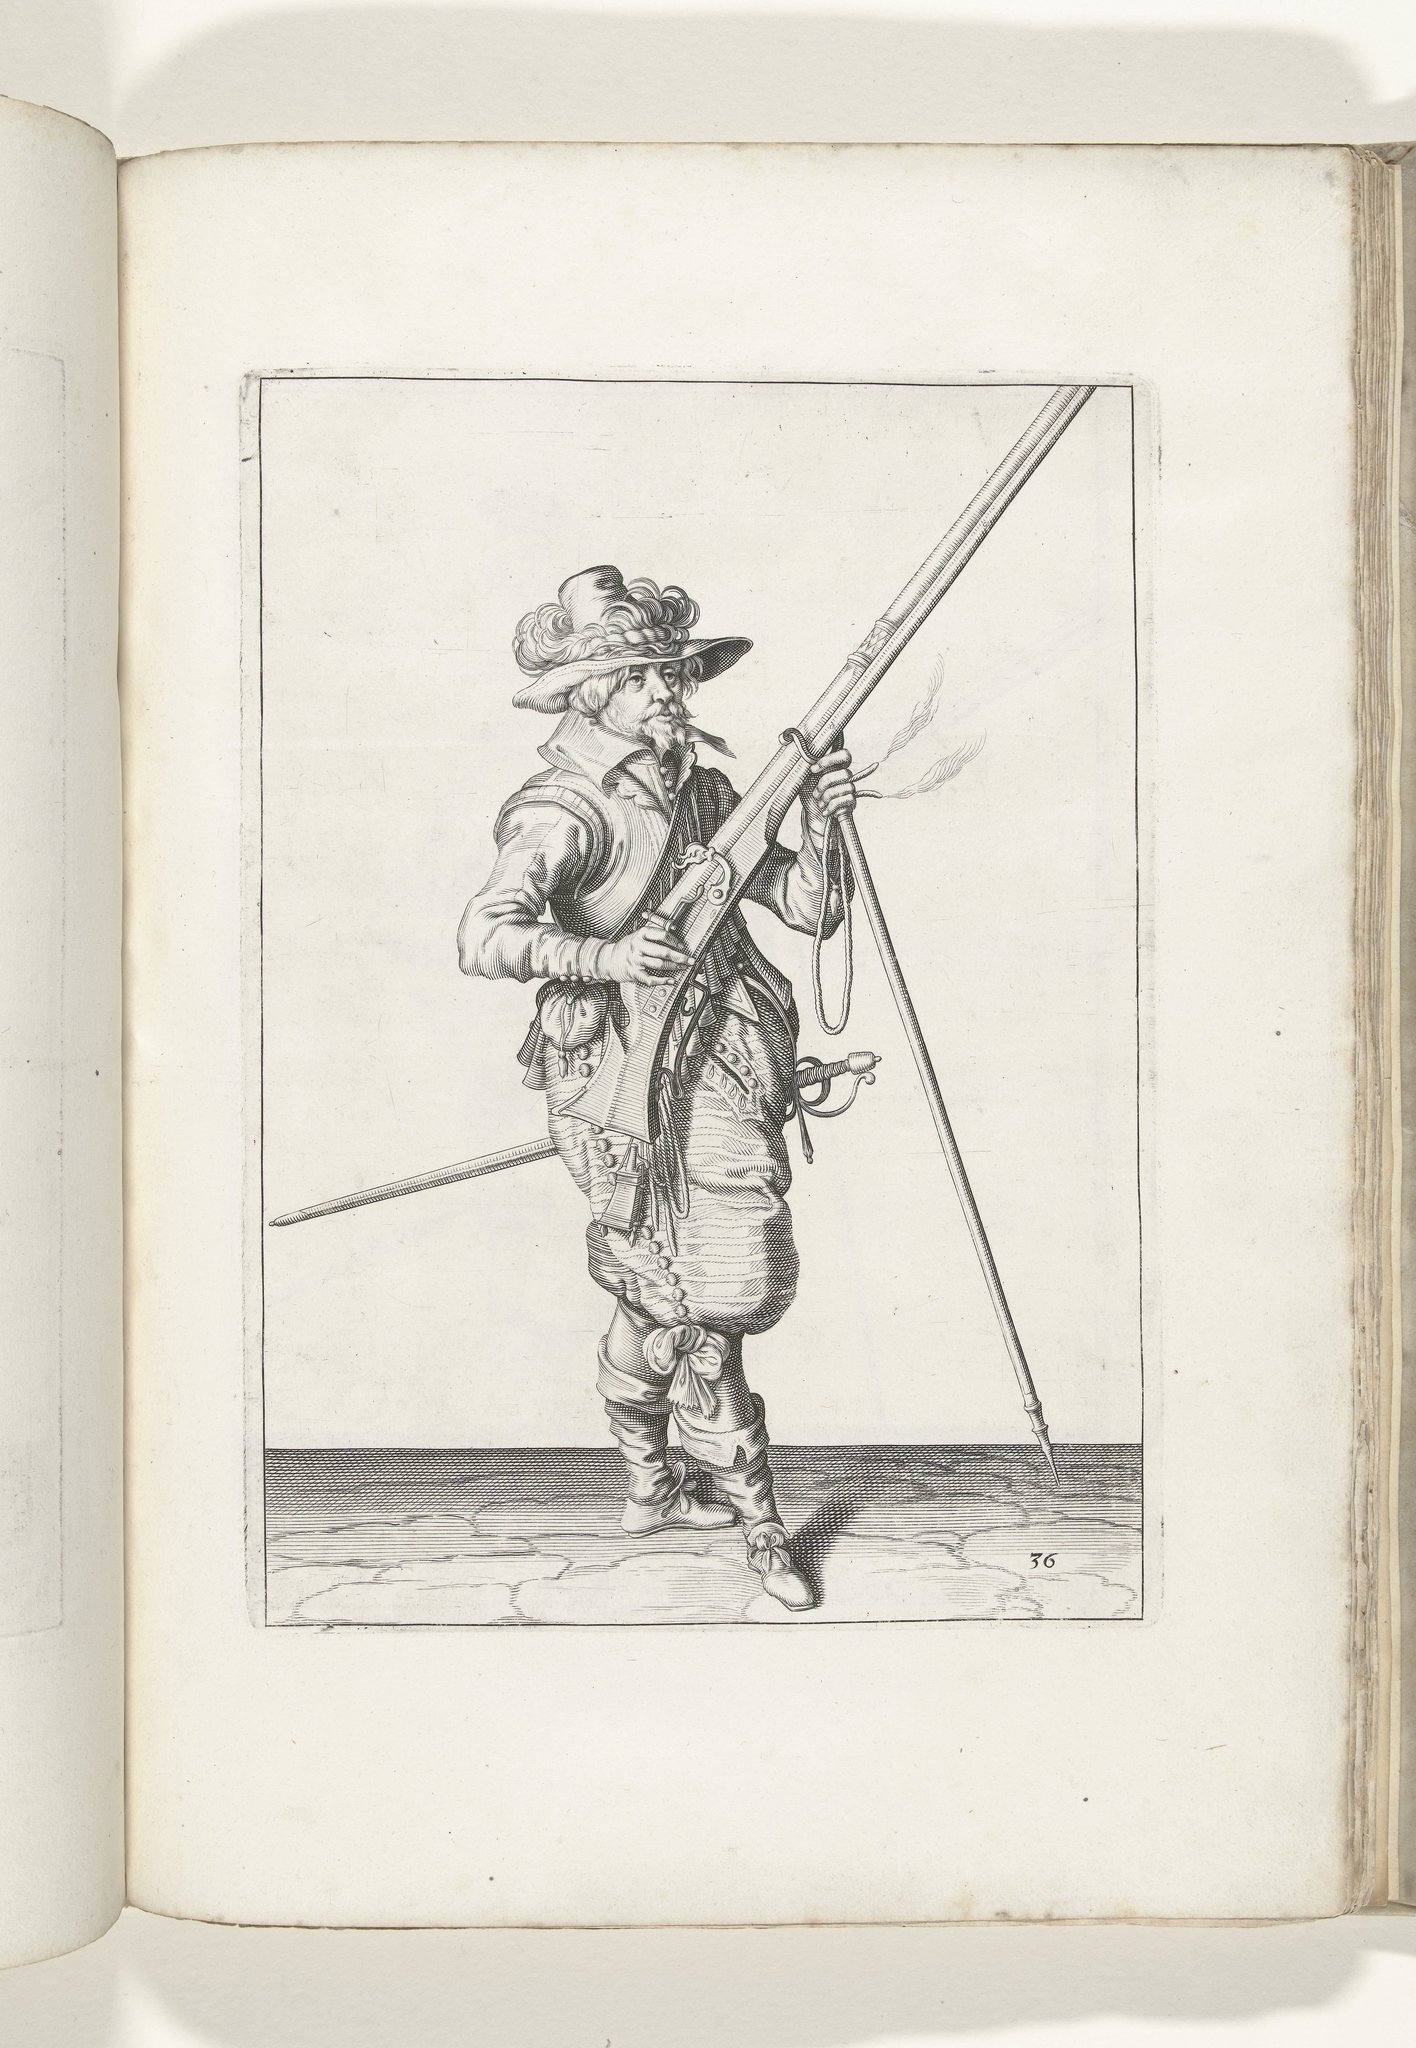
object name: print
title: Soldaat op wacht die zijn musket met zijn rechterhand schuin omhoog gericht vasthoudt, terwijl hij de loop met zijn linkerhand op zijn furket plaatst (nr. 36), ca. 1600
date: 1597-1607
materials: paper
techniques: engraving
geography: northern netherlands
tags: the hague, maurice (prince of orange), handling of weapons ~ military training, weapons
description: Een soldaat op wacht, ten voeten uit, naar rechts, die een musket (een bepaald type vuurwapen) met zijn rechterhand vasthoudt, de loop schuin omhoog gericht (nr. 36), ca. 1600. Hij plaatst de loop met zijn linkerhand, waarin ook een brandende lont, op zijn furket (musketvork). Plaat 36 in de instructies voor het hanteren van het musket: Corte onderrechtinghe op de figuerliicke afbeeldinghe, soo veel aengaet het recht ghebruyck vant Musquet. Onderdeel van de illustraties in: J. de Gheyn, Wapenhandelinghe van Roers Musquetten ende spiessen, 's-Gravenhage, 1607. Krijgswezen rond 1600.